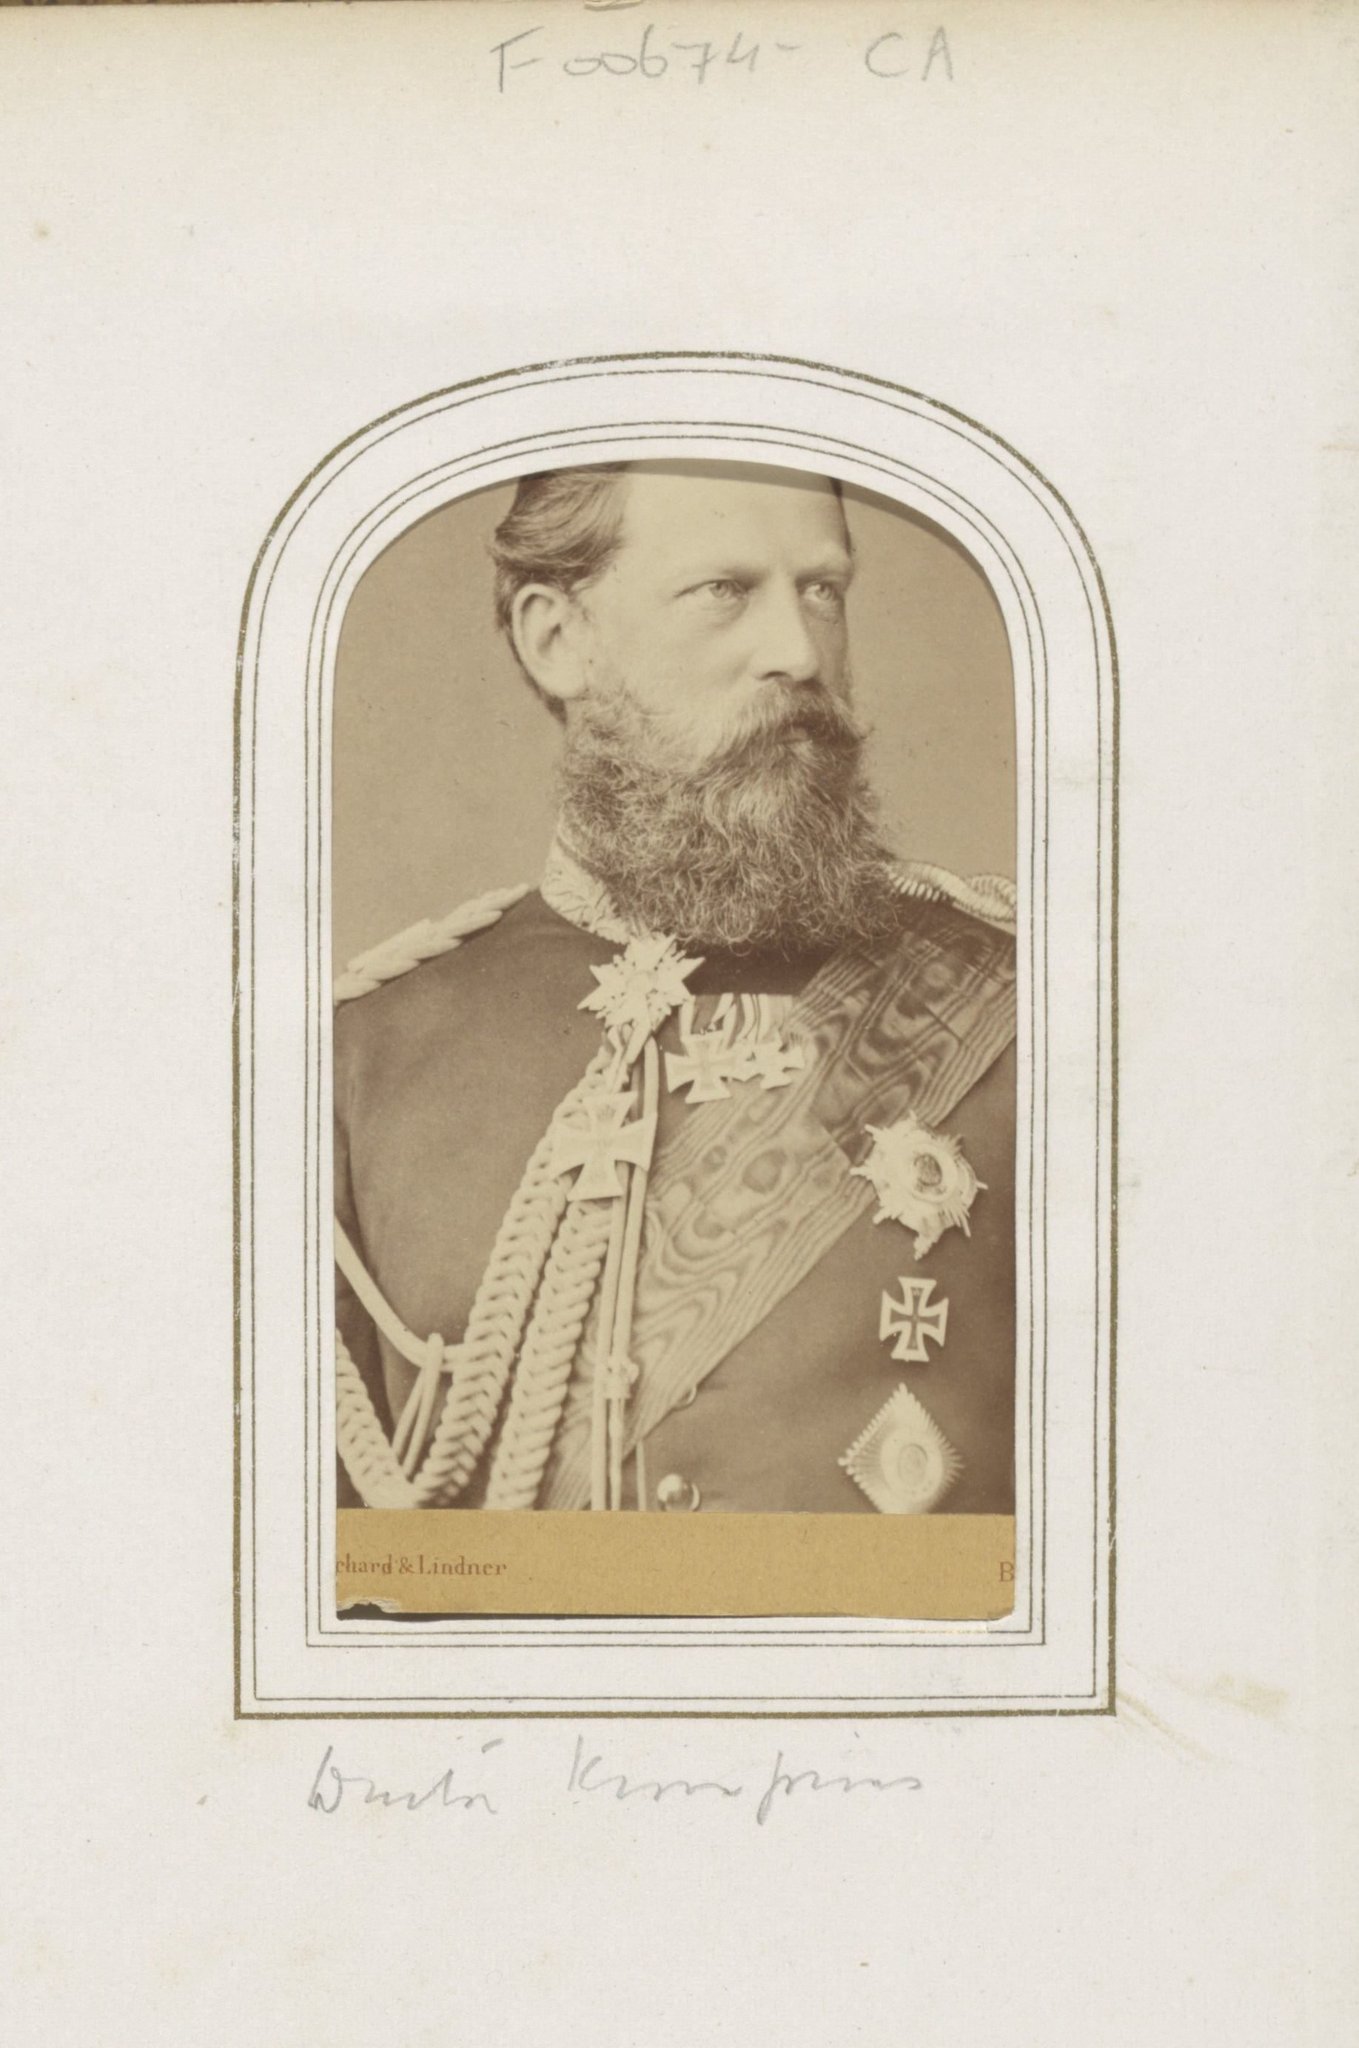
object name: photograph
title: Portret van Friedrich Wilhelm, kroonprins van Pruisen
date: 1870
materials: cardboard, paper, photographic support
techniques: albumen print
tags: historical persons, medals and other marks of military honour, hairdress, decorations, honours (as symbols of the state, etc.), (military) uniforms, beard, crown prince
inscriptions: address: ‘Berlin, Markgrafen-Strasse 40, Ecke der Mohren Strasse’, inscription: ‘Kronprinz’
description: Onderdeel van Fotoalbum met 123 cartes-de-visite van leden van Europese vorstenhuizen, politici en bekende personen.